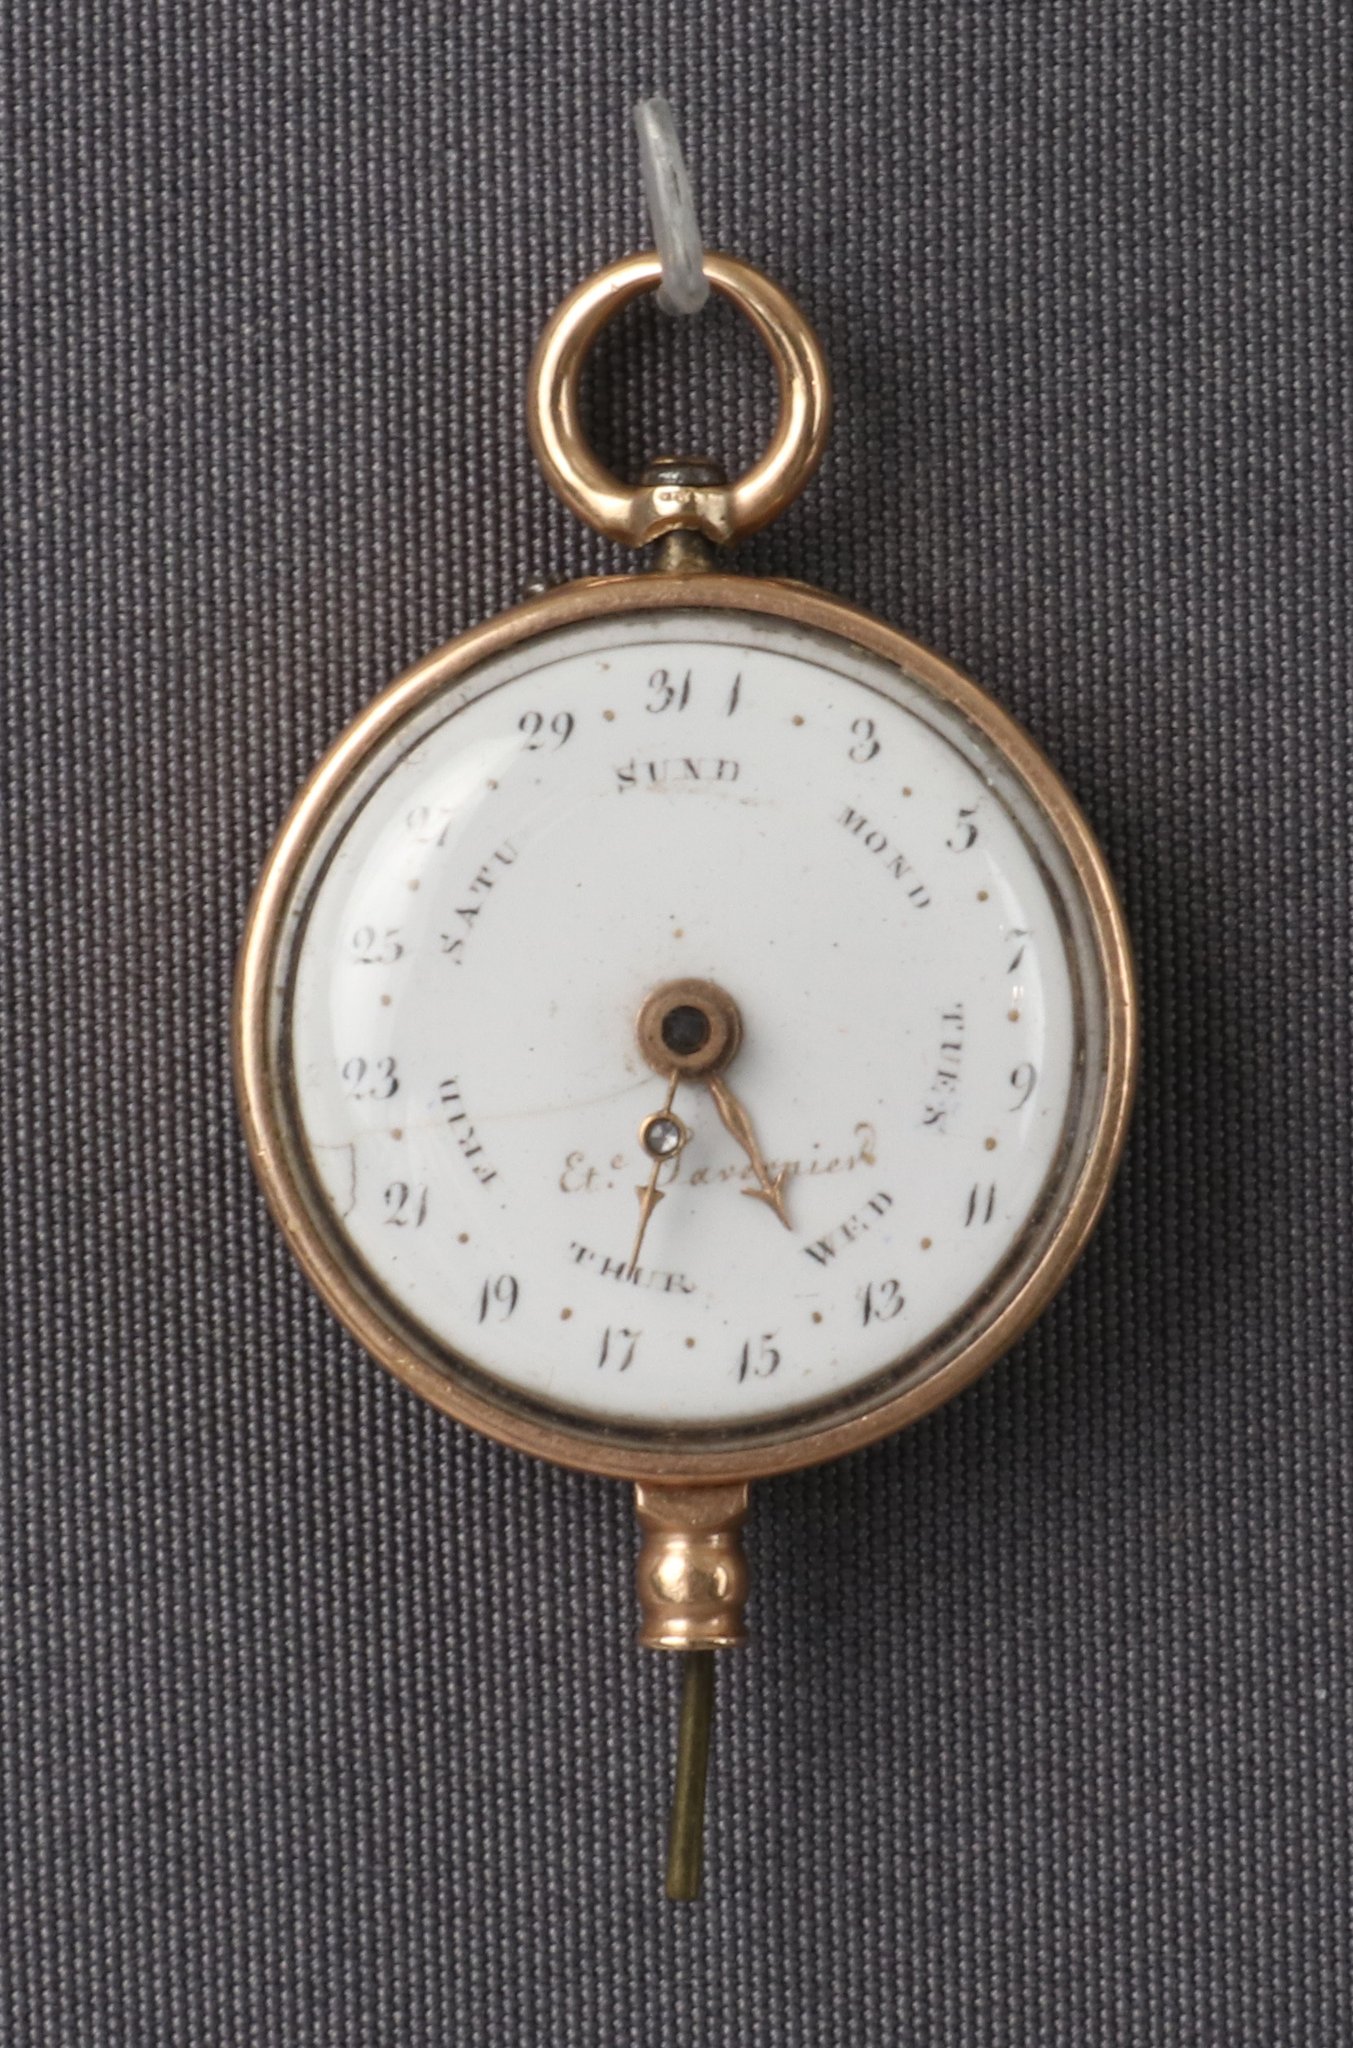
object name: watch calendar key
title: Calendar key for a watch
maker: etienne tavernier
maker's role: maker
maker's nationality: french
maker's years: 1756-1839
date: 1800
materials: enamel, gold